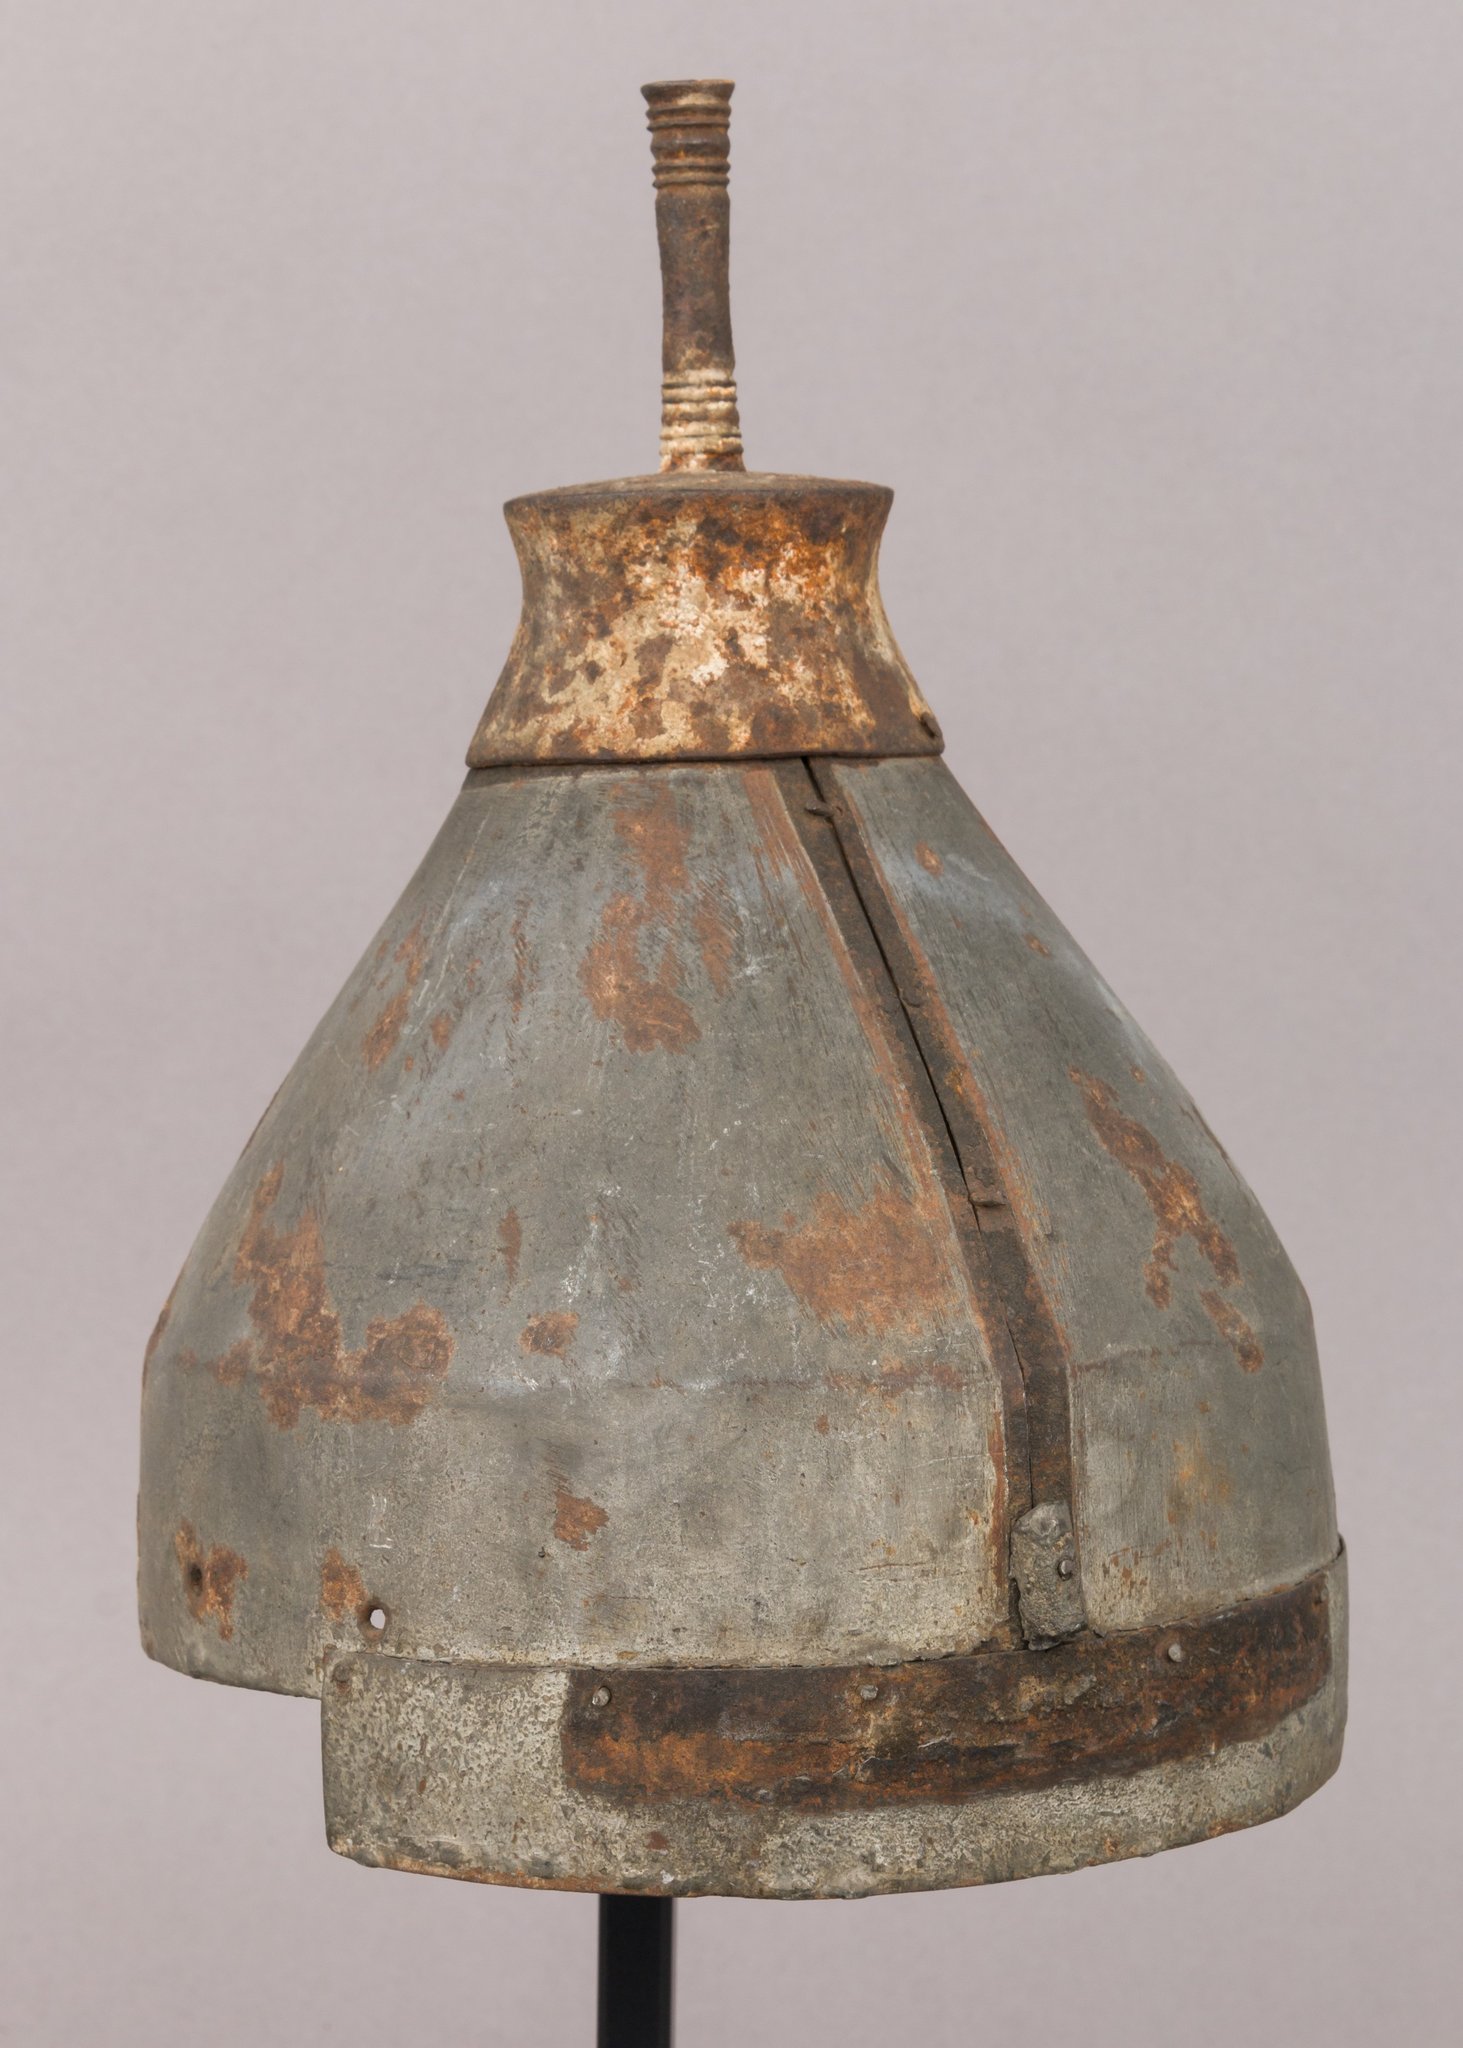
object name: helmet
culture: chinese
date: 1701-1900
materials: metal alloy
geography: china